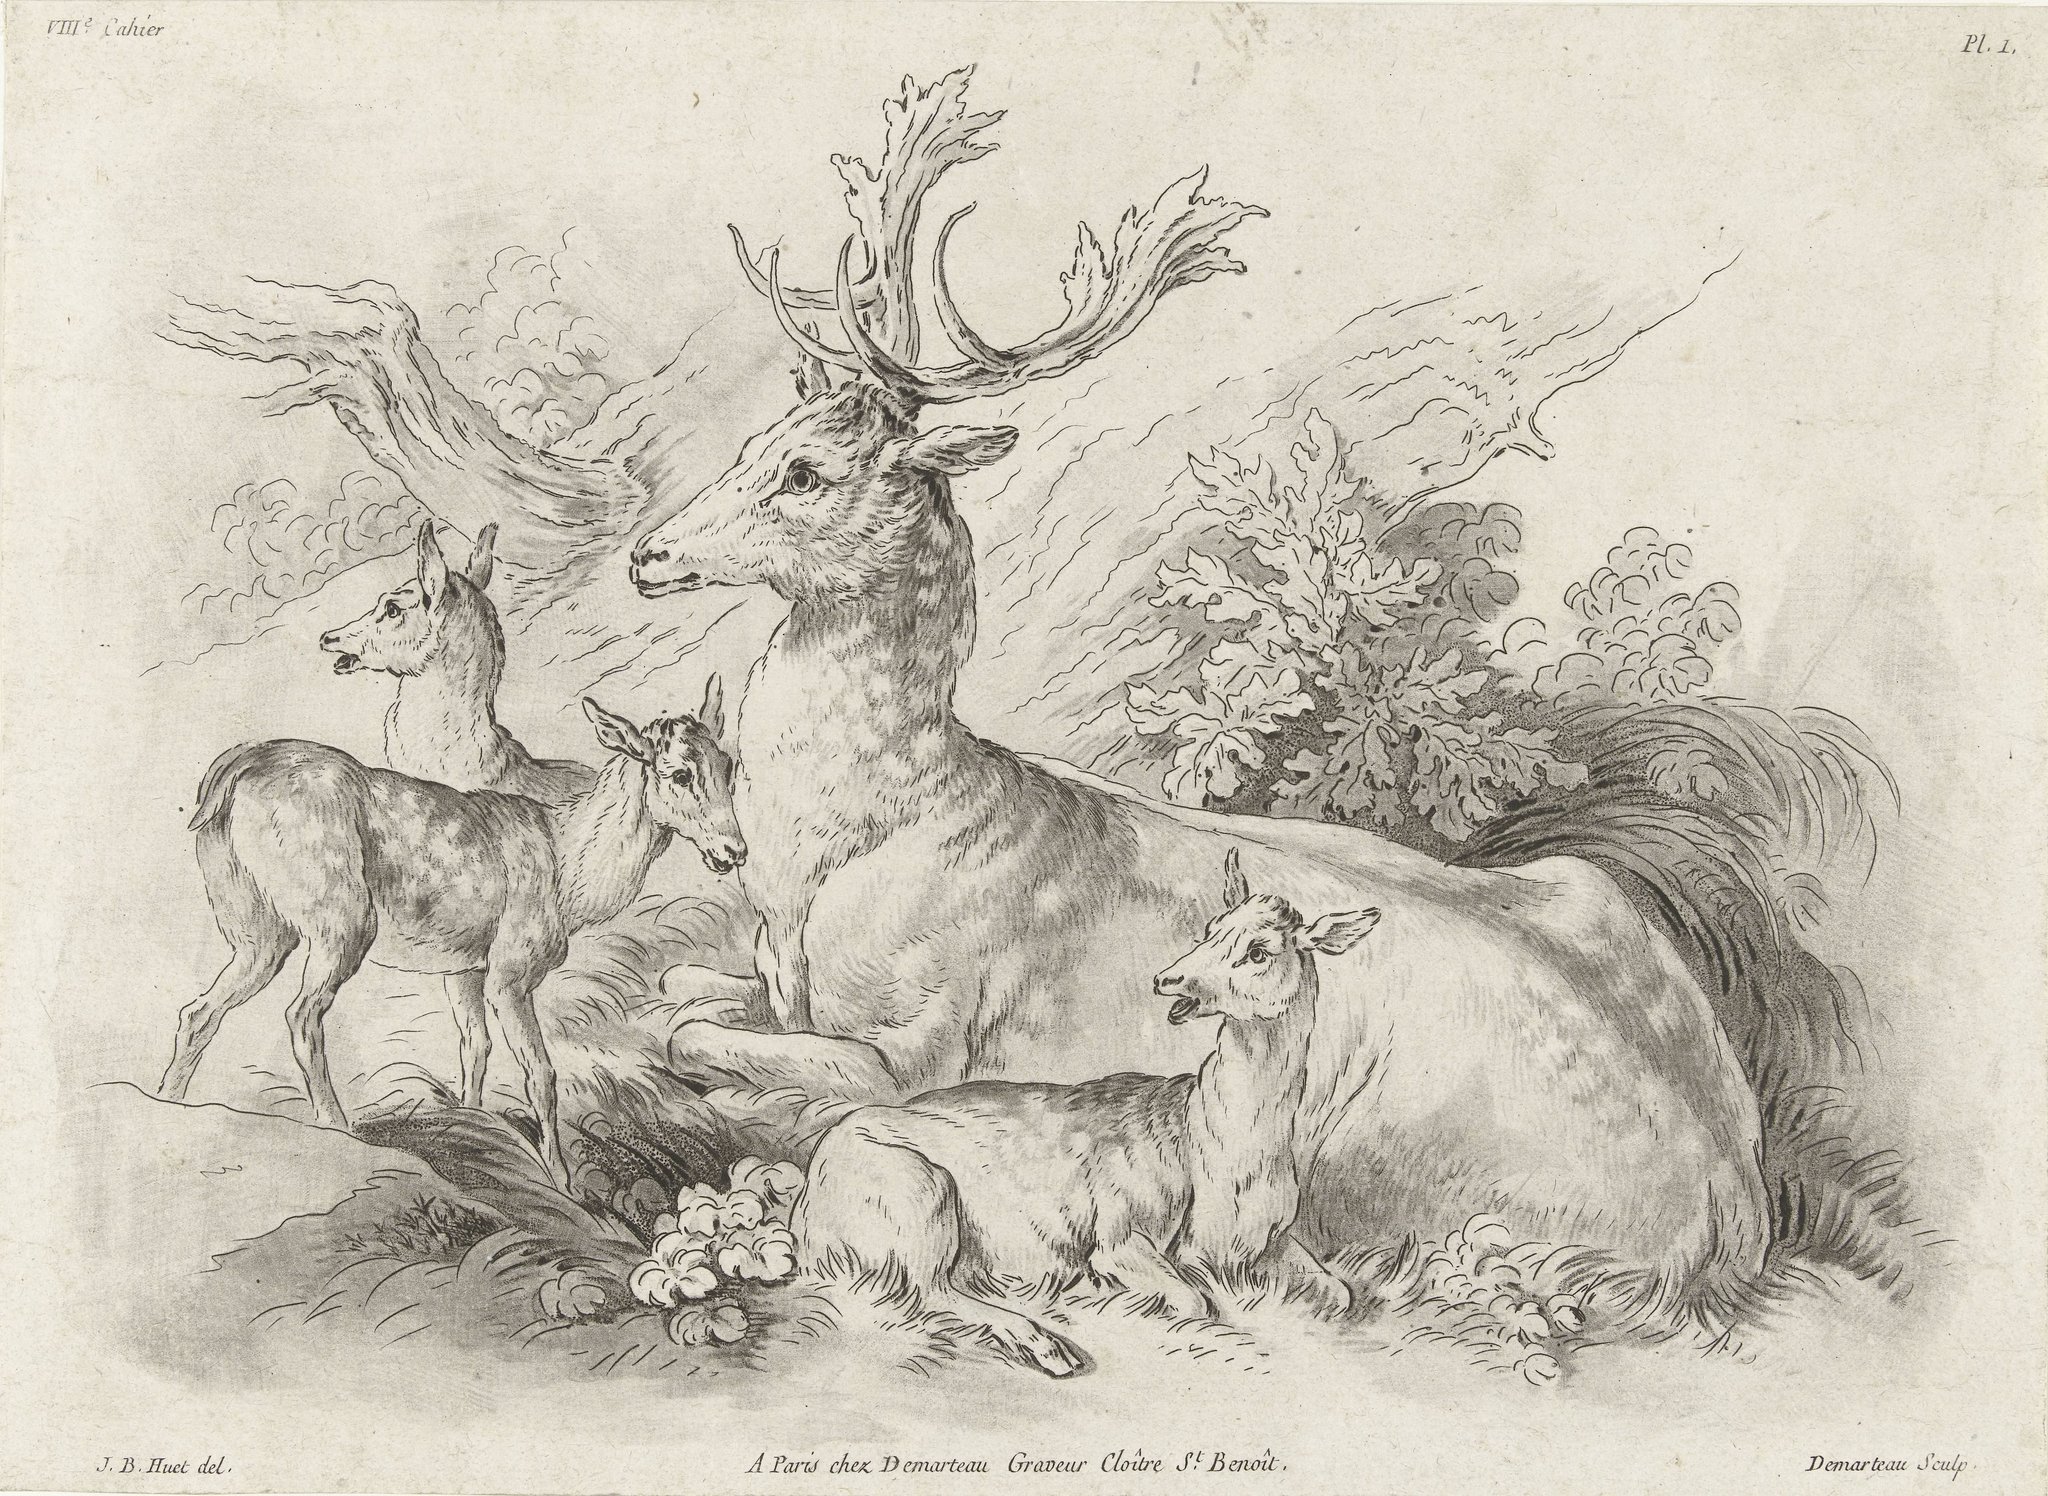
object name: print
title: Rustende herten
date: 1732-1776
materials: paper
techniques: printmaking, etching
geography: paris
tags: hoofed animals: deer, hoofed animals: stag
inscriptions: collector's mark: Lugt 2228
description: Prent uit onbekende uitgave: VIIIe Cahier, plaat 1.